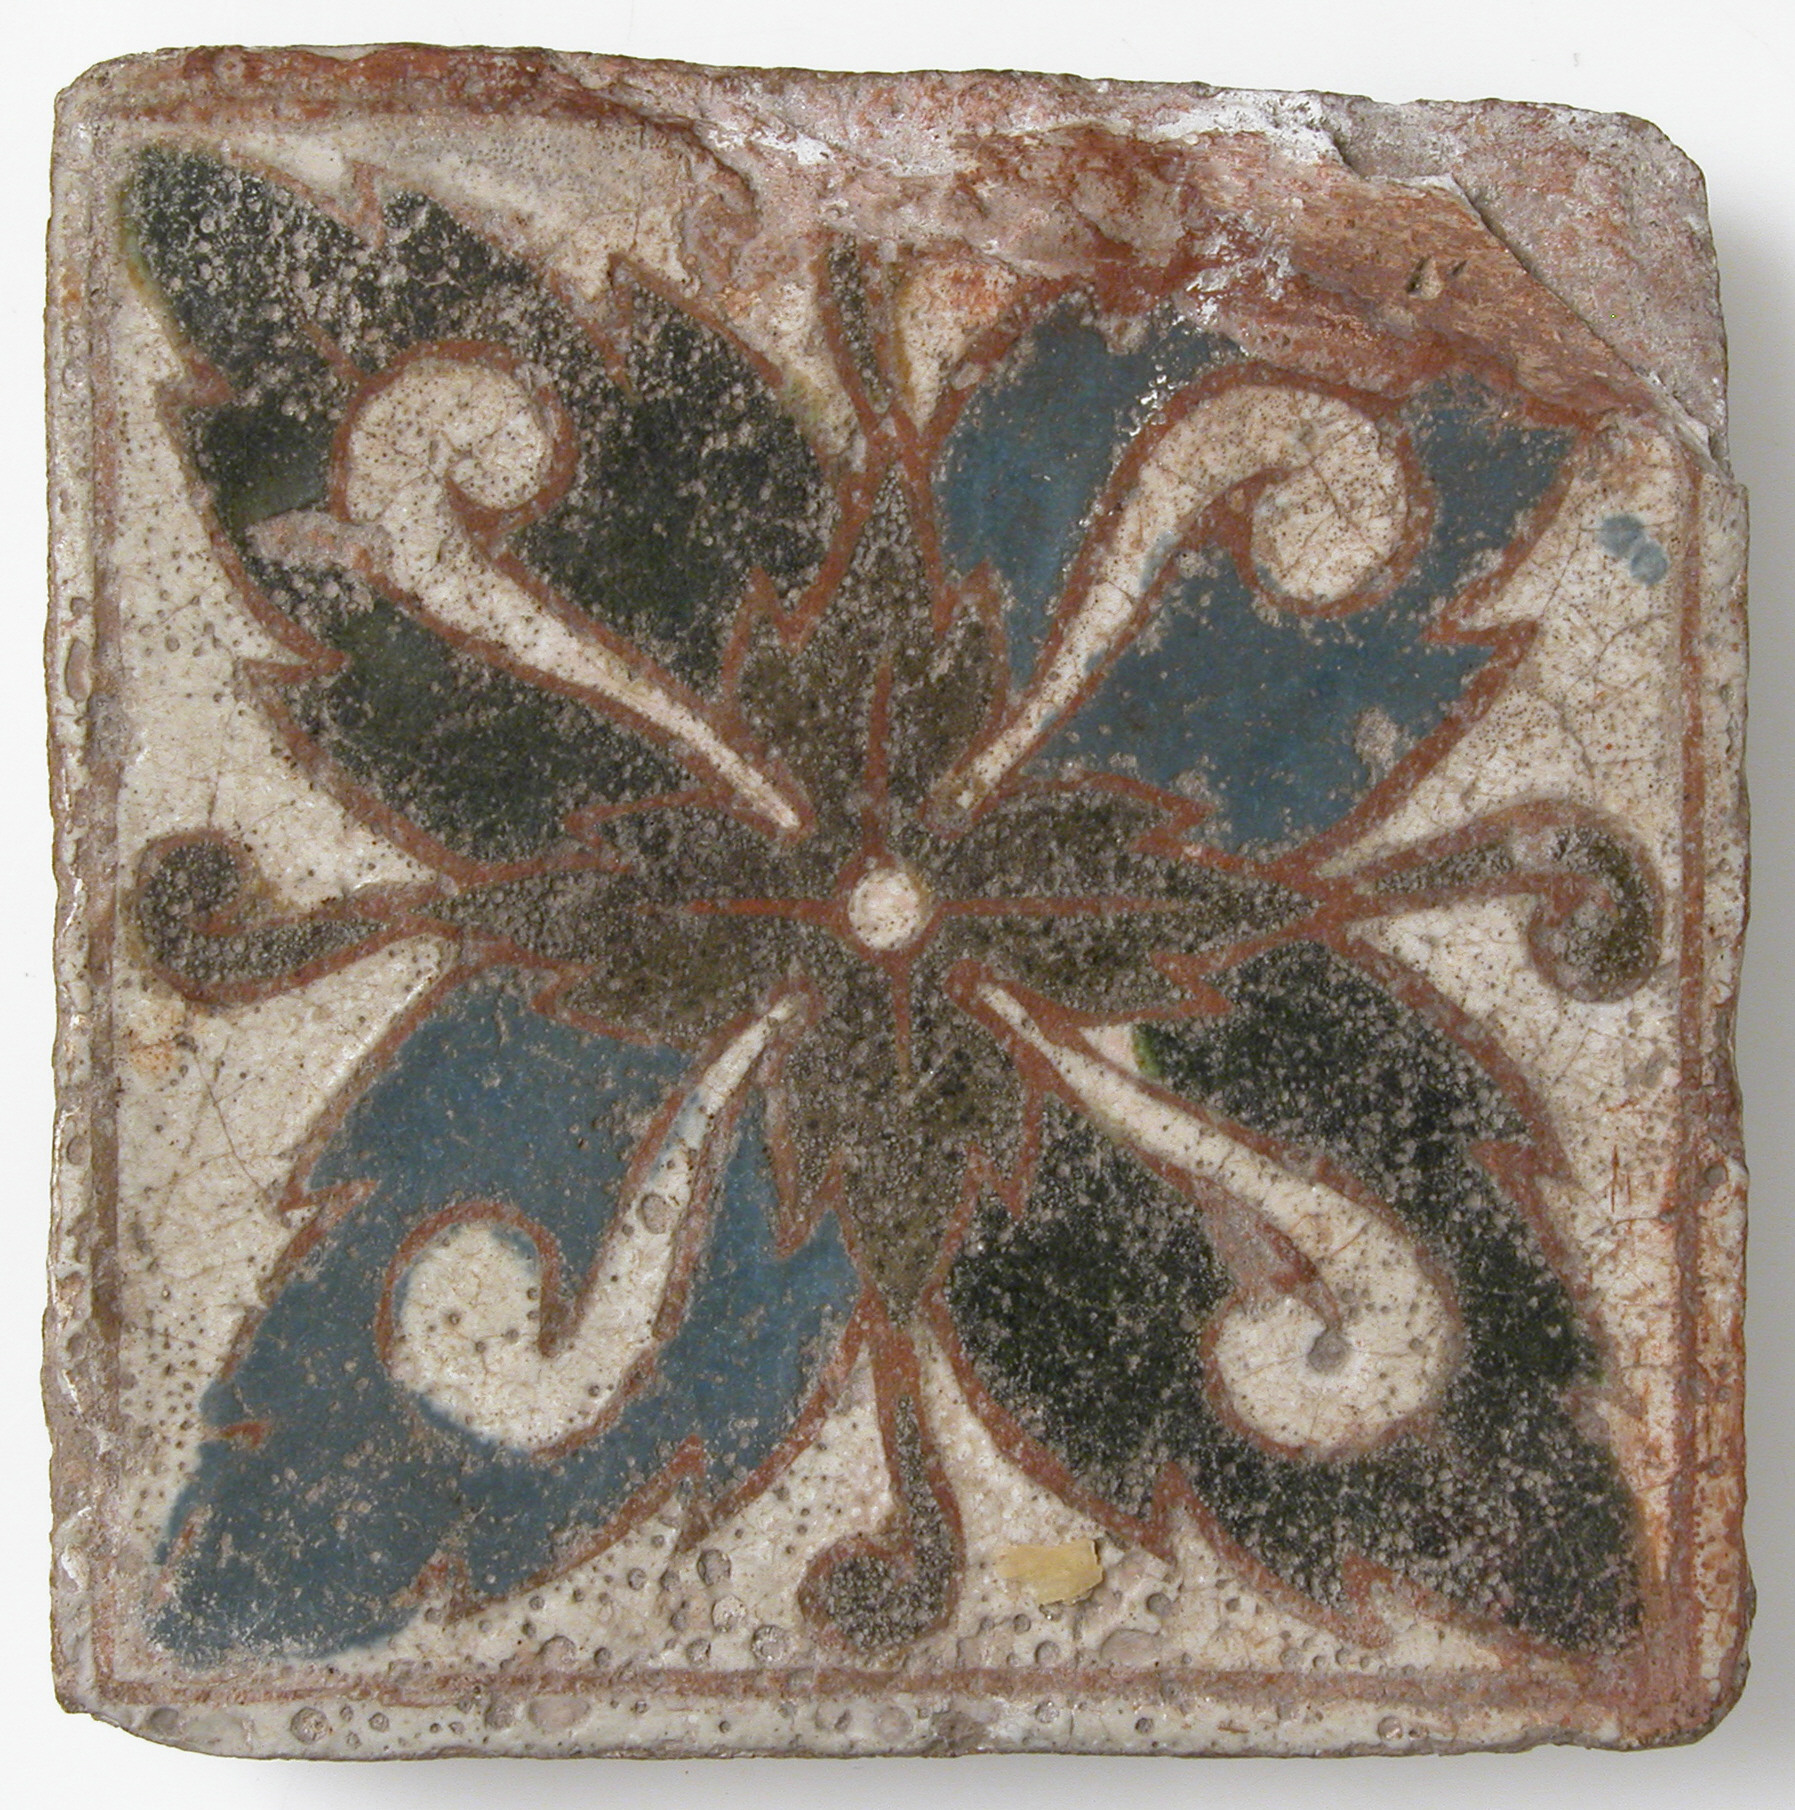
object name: tile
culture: spanish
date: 1401-1600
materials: earthenware, glaze